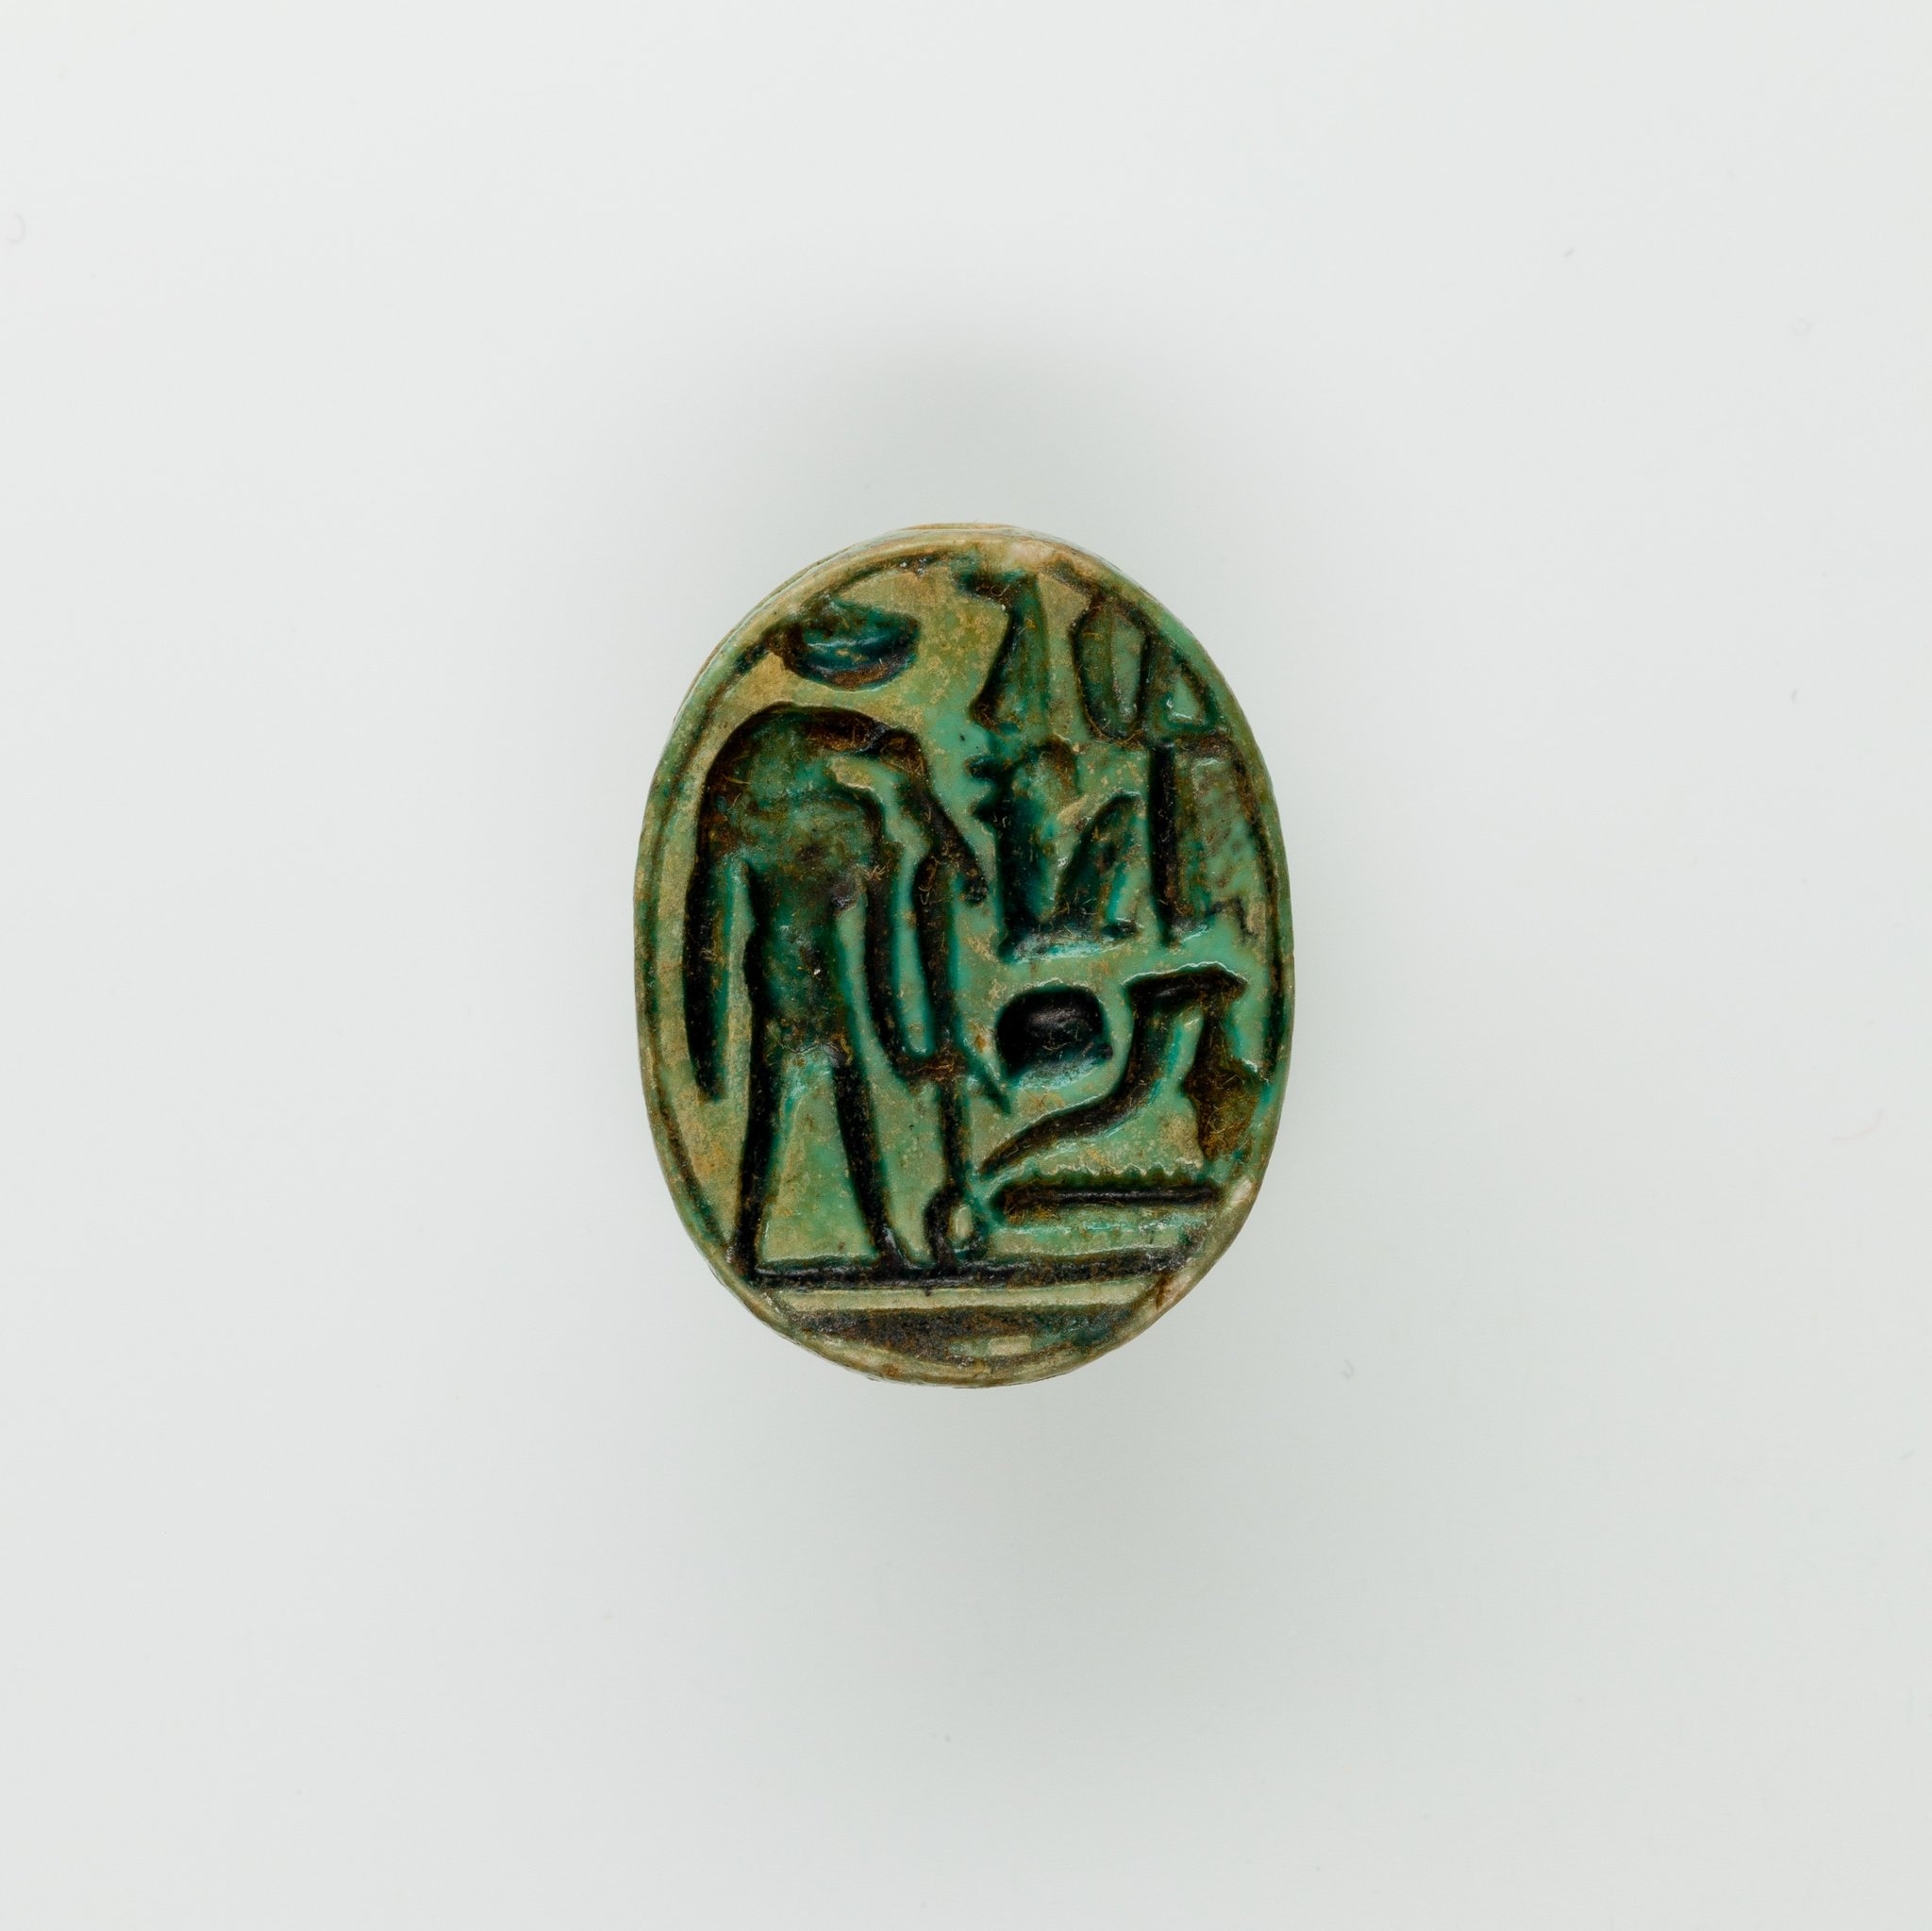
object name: scarab, ramesses ii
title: Scarab of Ramesses II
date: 1295-1070 BCE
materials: stone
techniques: glazing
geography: egypt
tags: hieroglyphs,scarabs